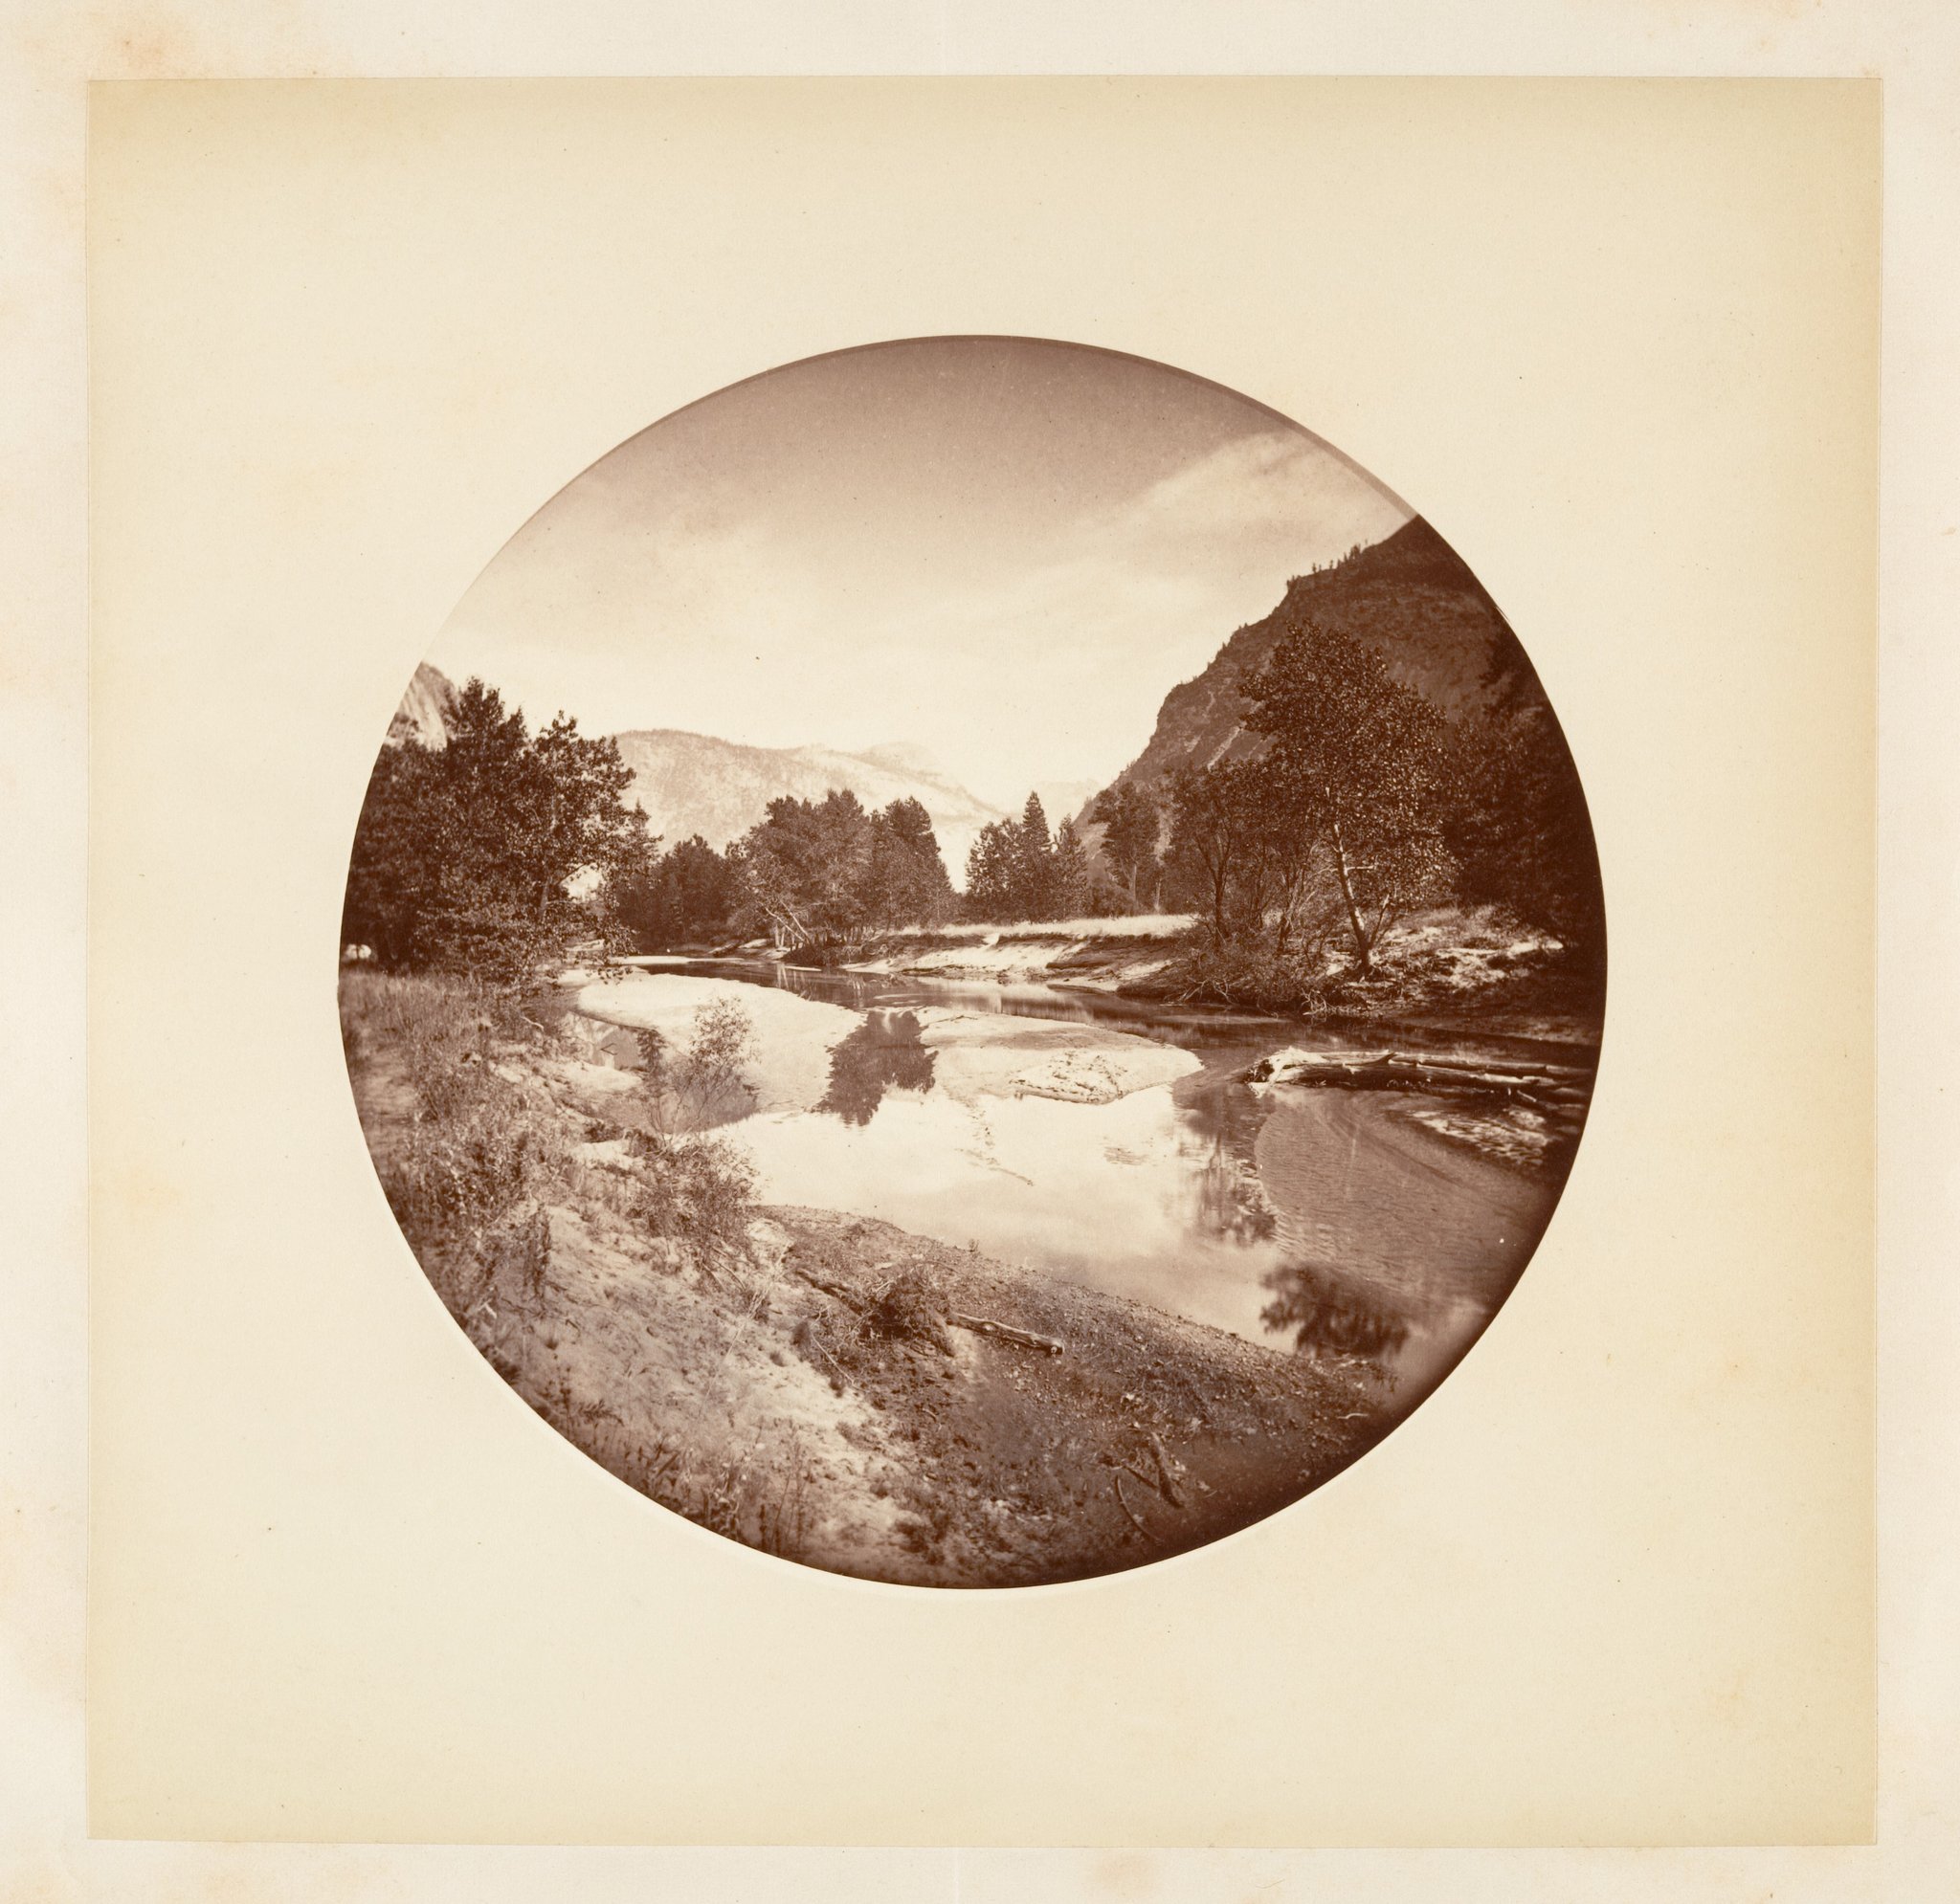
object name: photograph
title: [Yosemite National Park, California]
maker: carleton e. watkins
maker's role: artist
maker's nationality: american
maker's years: 1829-1916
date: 1878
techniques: albumen silver print, glass negative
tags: landscapes